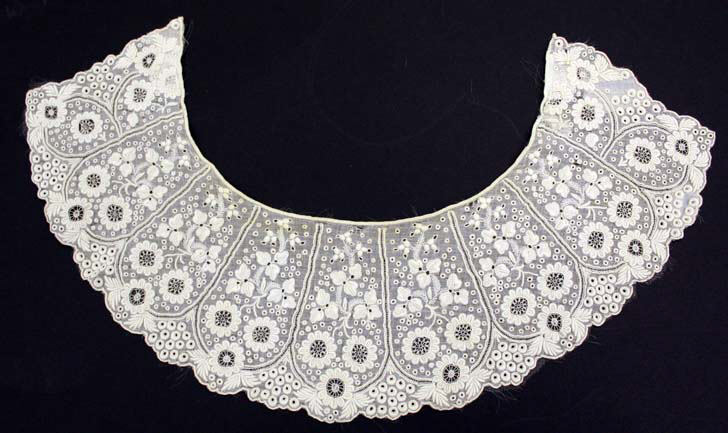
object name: collar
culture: american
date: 1850-1859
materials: cotton